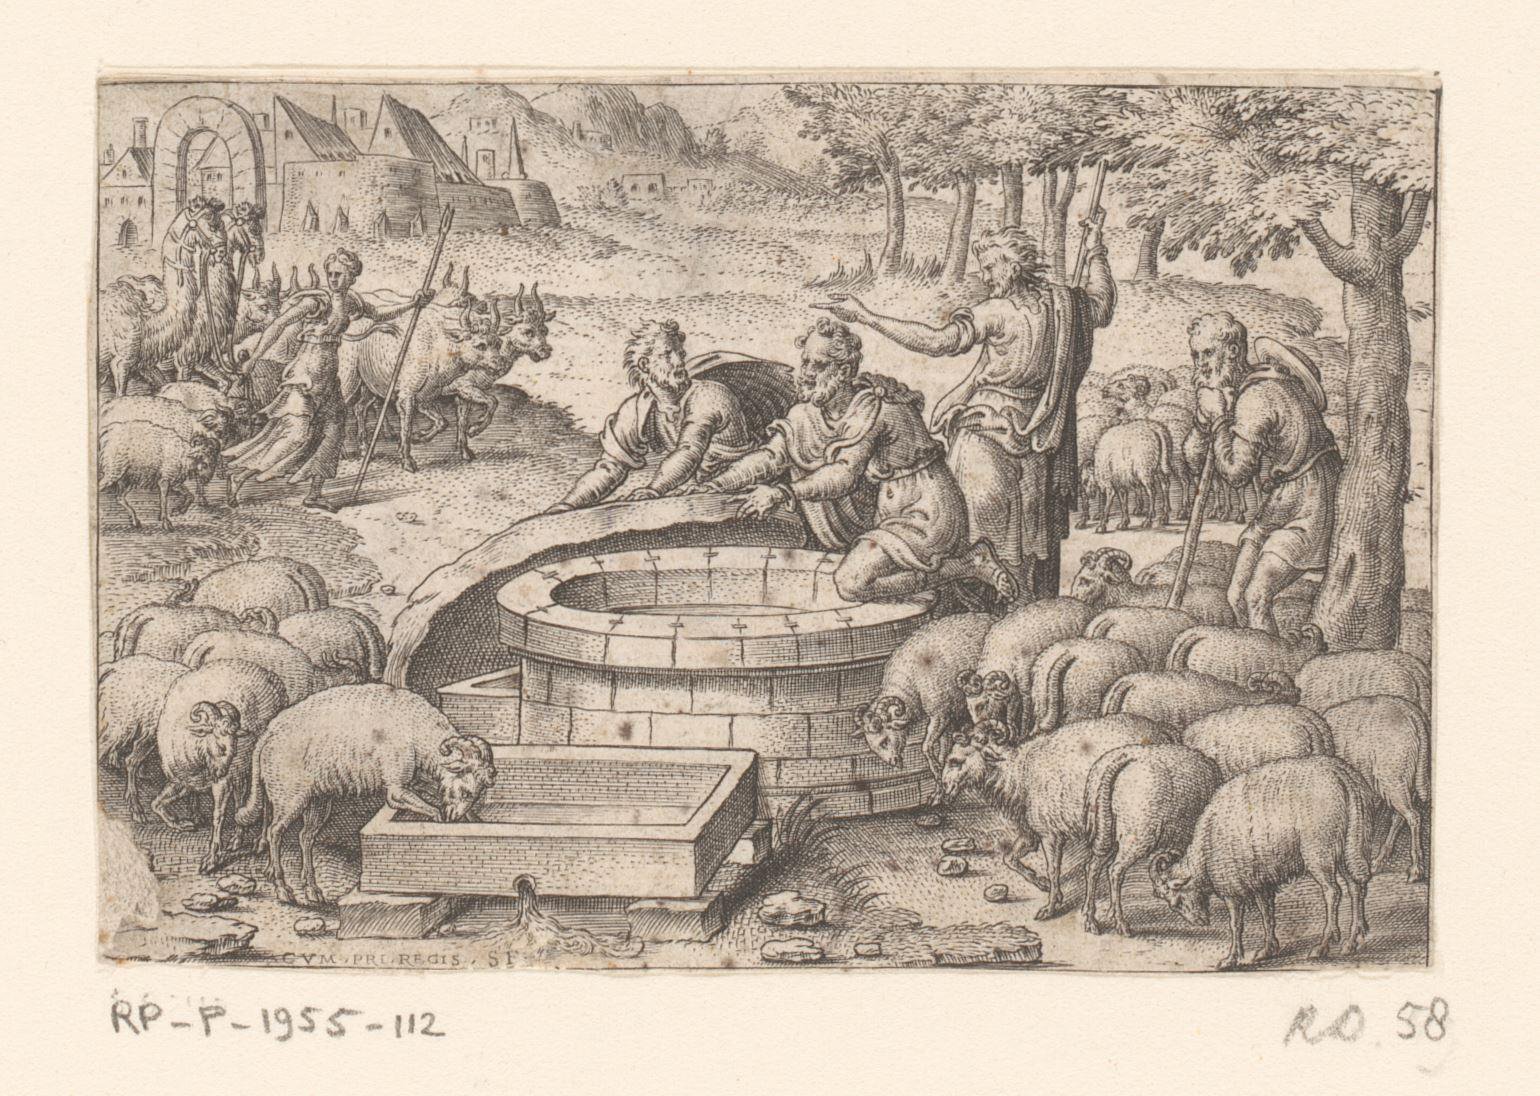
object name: print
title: Jakob tilt de steen van de put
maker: etienne delaune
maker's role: draughtsman, goldsmith, print maker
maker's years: 1519-1583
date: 1569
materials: paper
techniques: engraving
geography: france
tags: jacob sees rachel coming to the well to water laban's sheep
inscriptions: collector's mark: Lugt 2228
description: Rachel brengt de schapen van haar vader Laban naar de put. Jakob tilt de steen van de opening, zodat de schapen kunnen drinken.